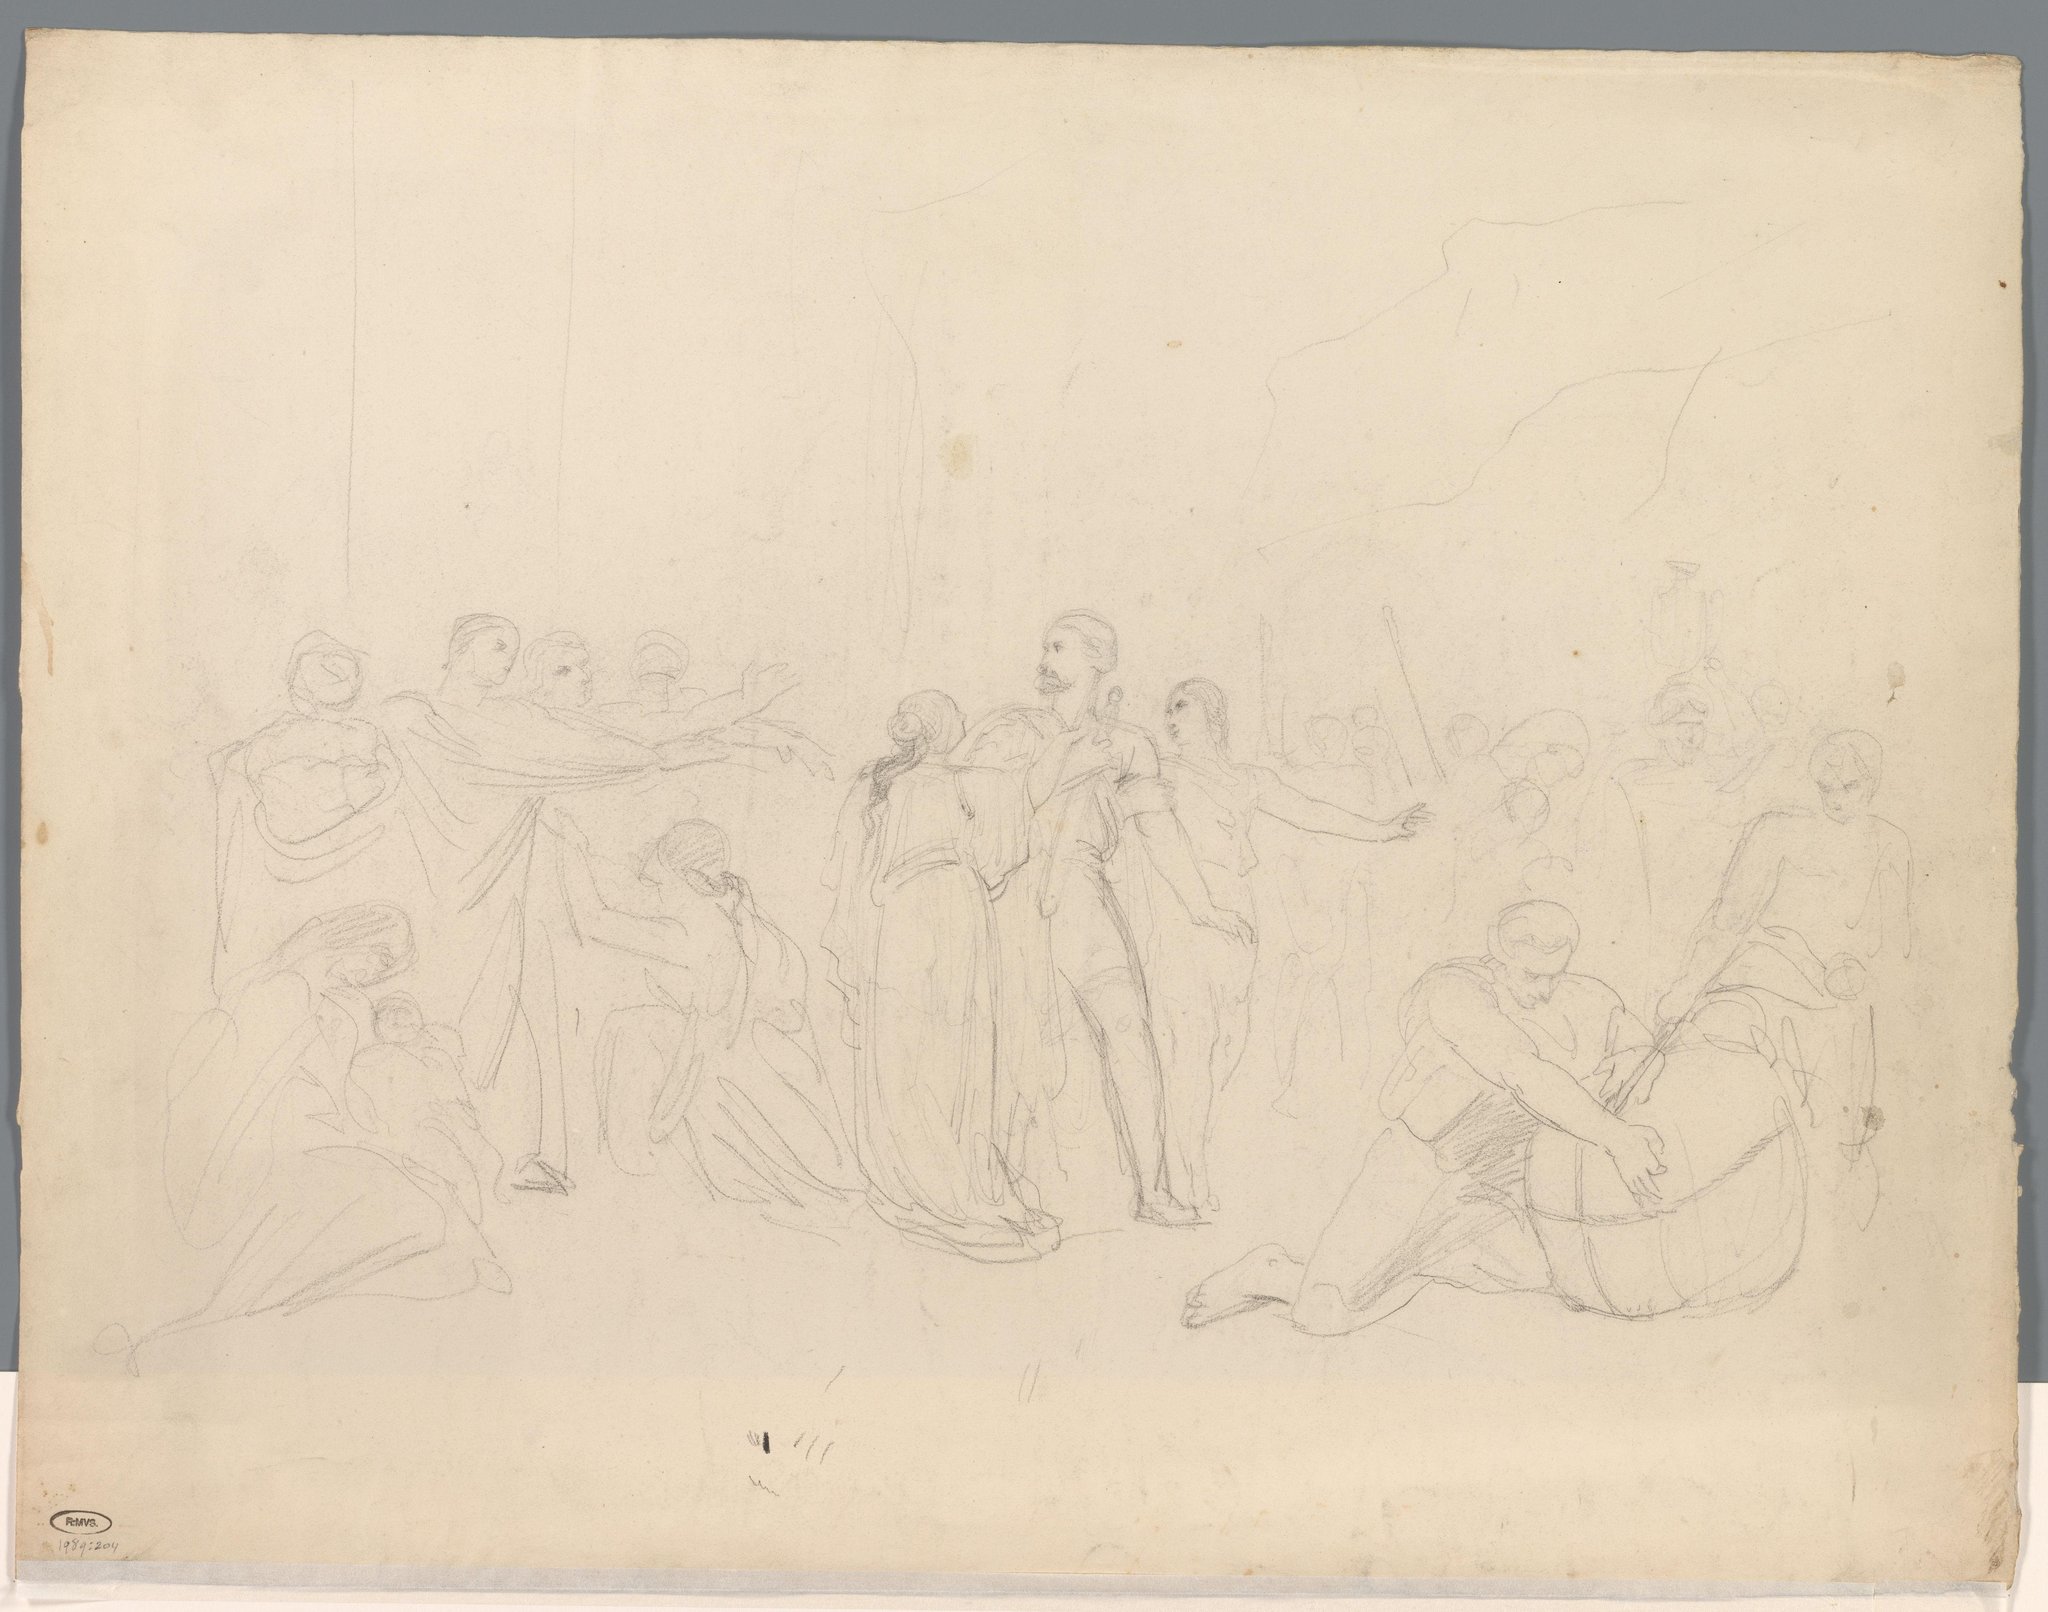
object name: drawing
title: Historische voorstelling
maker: jacobus everhardus josephus van den berg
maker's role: draughtsman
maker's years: 1802-1861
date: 1812-1861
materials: chalk, paper